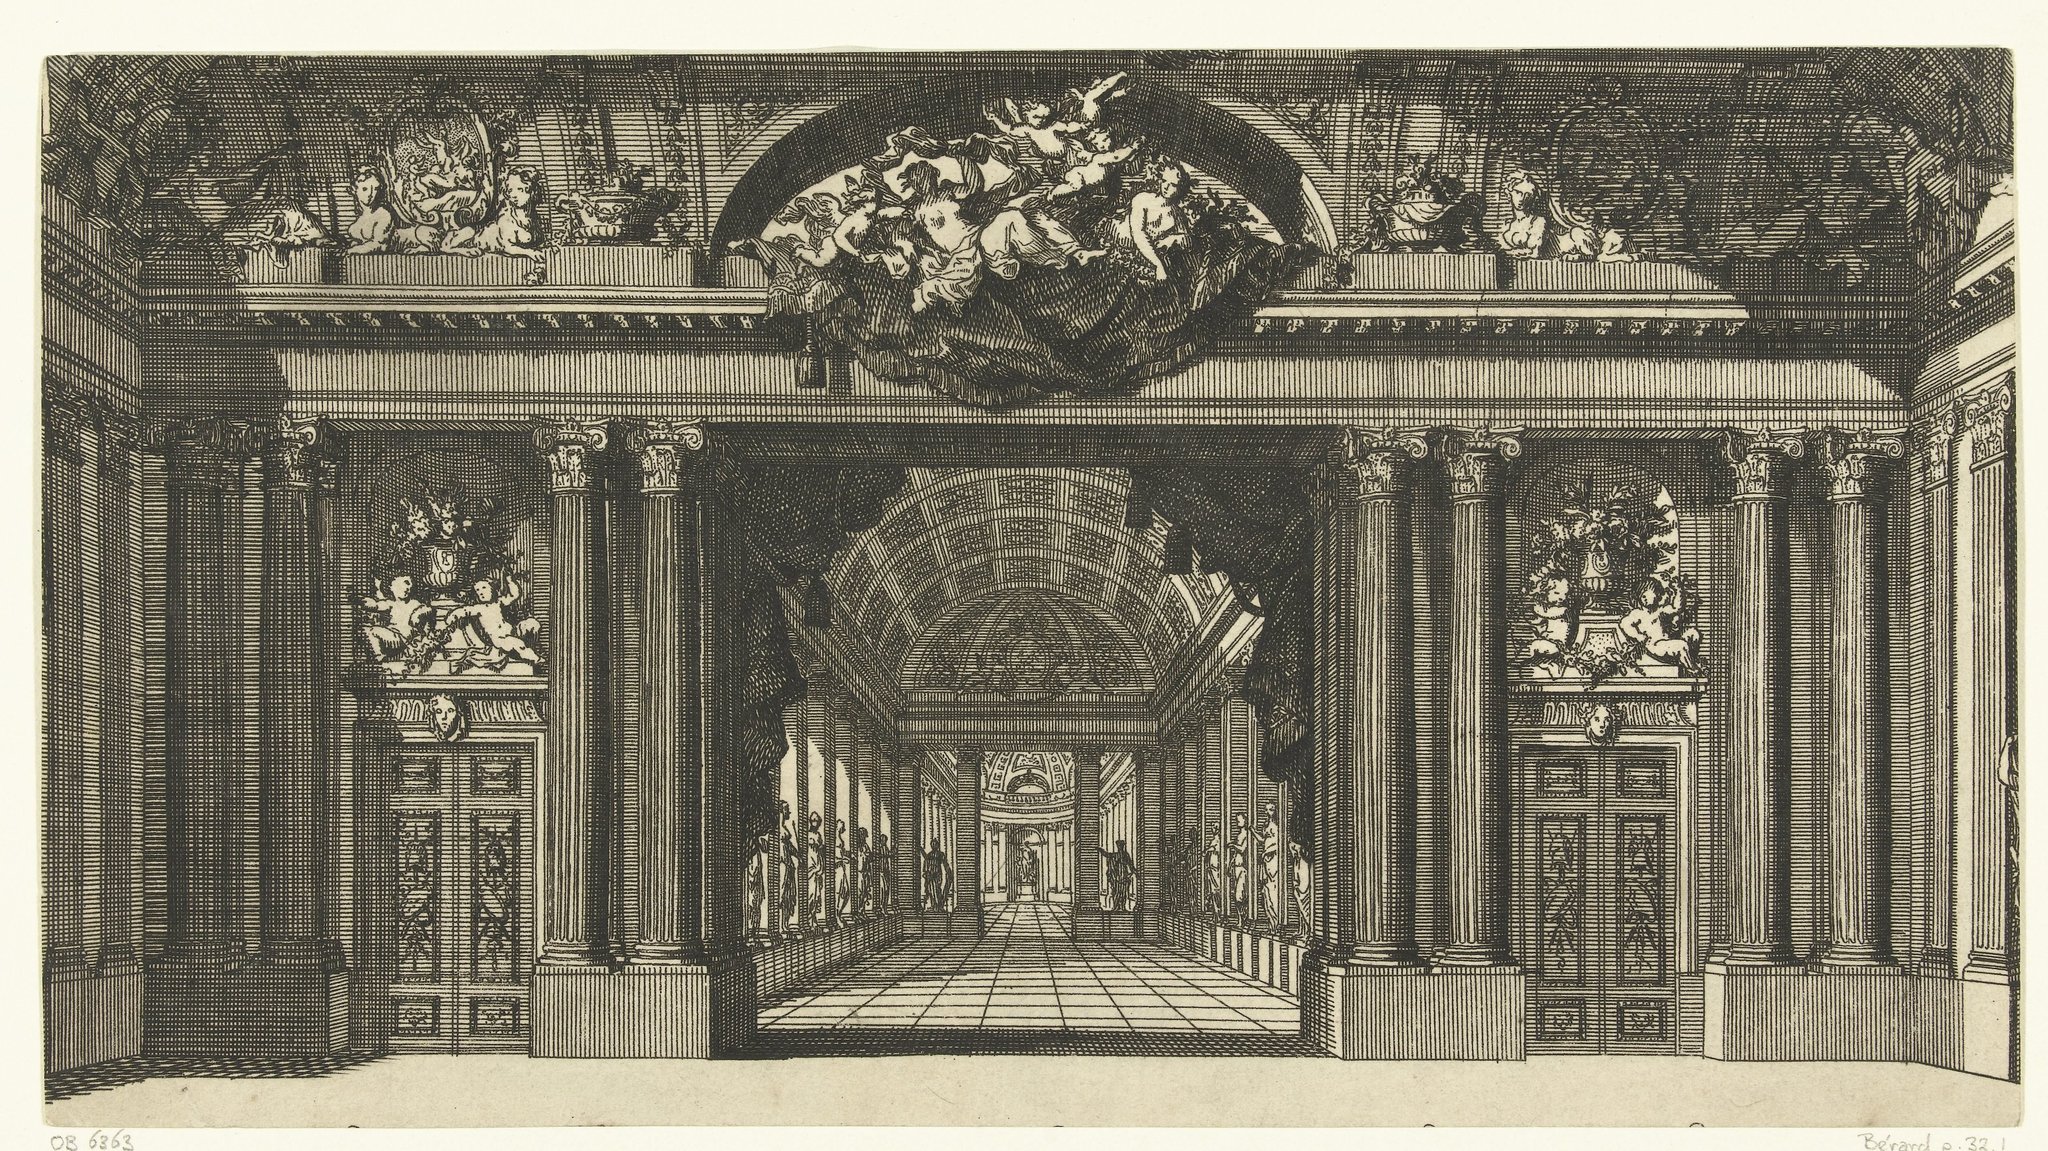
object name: ornament print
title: Titelblad: Nouveaux Liure de Pintures de Salles et d'Escalliers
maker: daniël marot (i)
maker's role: draughtsman, print maker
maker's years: 1661-1752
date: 1712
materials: paper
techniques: etching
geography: netherlands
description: Hal gedecoreerd met gekoppelde Korintische zuilen en uitzicht op een galerij met beelden. Blad uit serie met geschilderde muurdecoraties voor kamers en trappenhuizen.